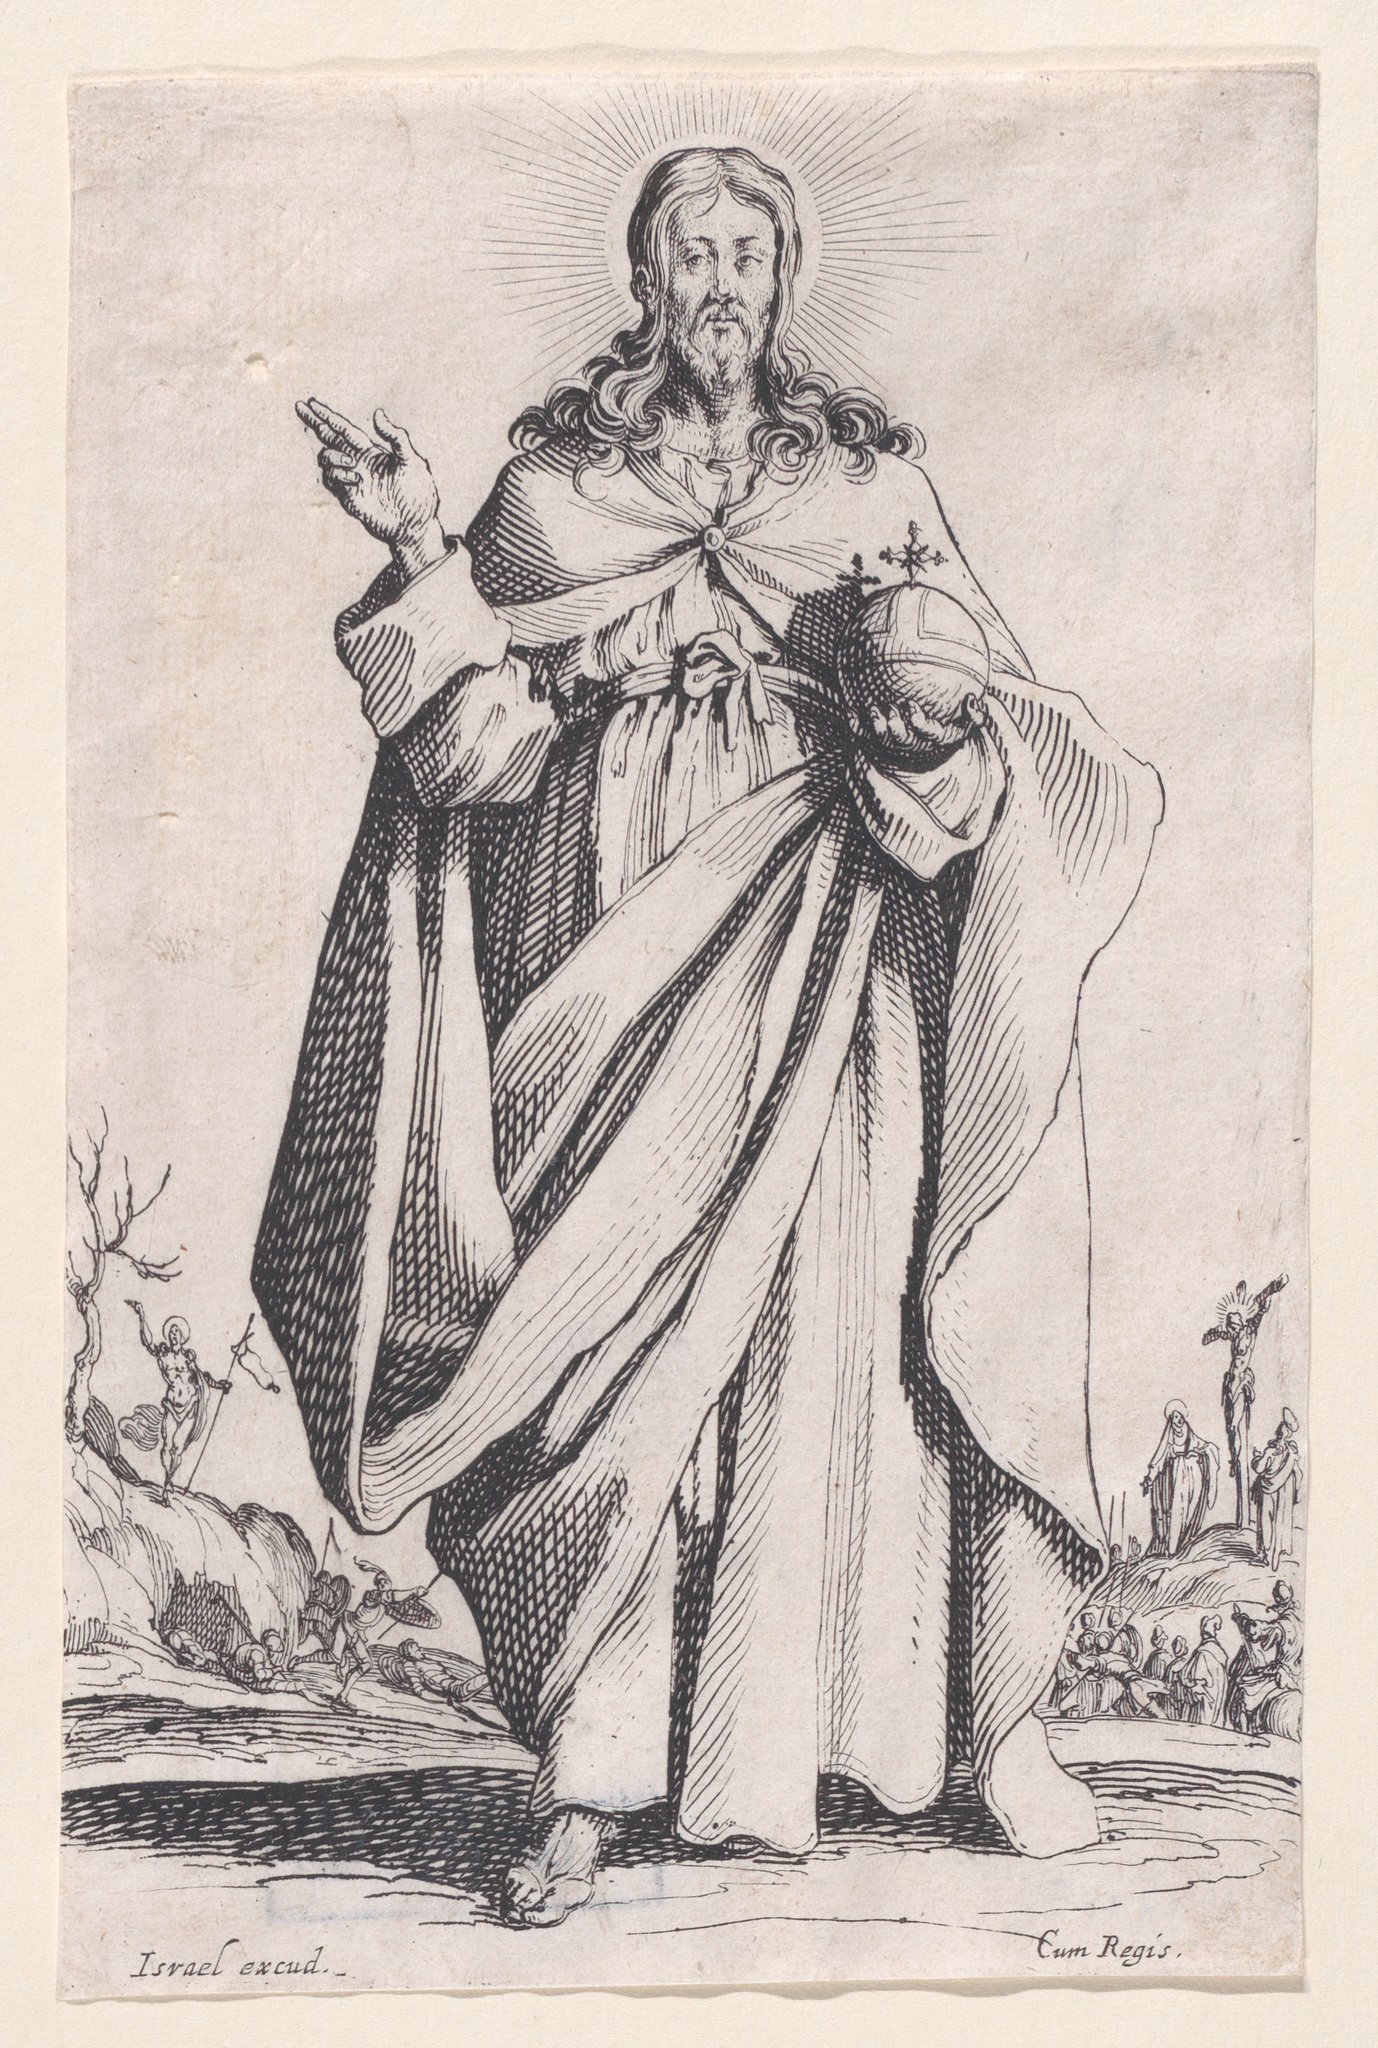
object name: print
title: St. Peter, from "Les Grands Apôtres Debout, Représentant Le Sauveur, La Bienheureuse Marie et Les Saints Apôtres" (The Large Standing Apostles, Representing The Savior, The Blessed Mary and The Apostles)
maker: jacques callot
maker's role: artist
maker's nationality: french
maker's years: 1592-1635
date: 1631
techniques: etching